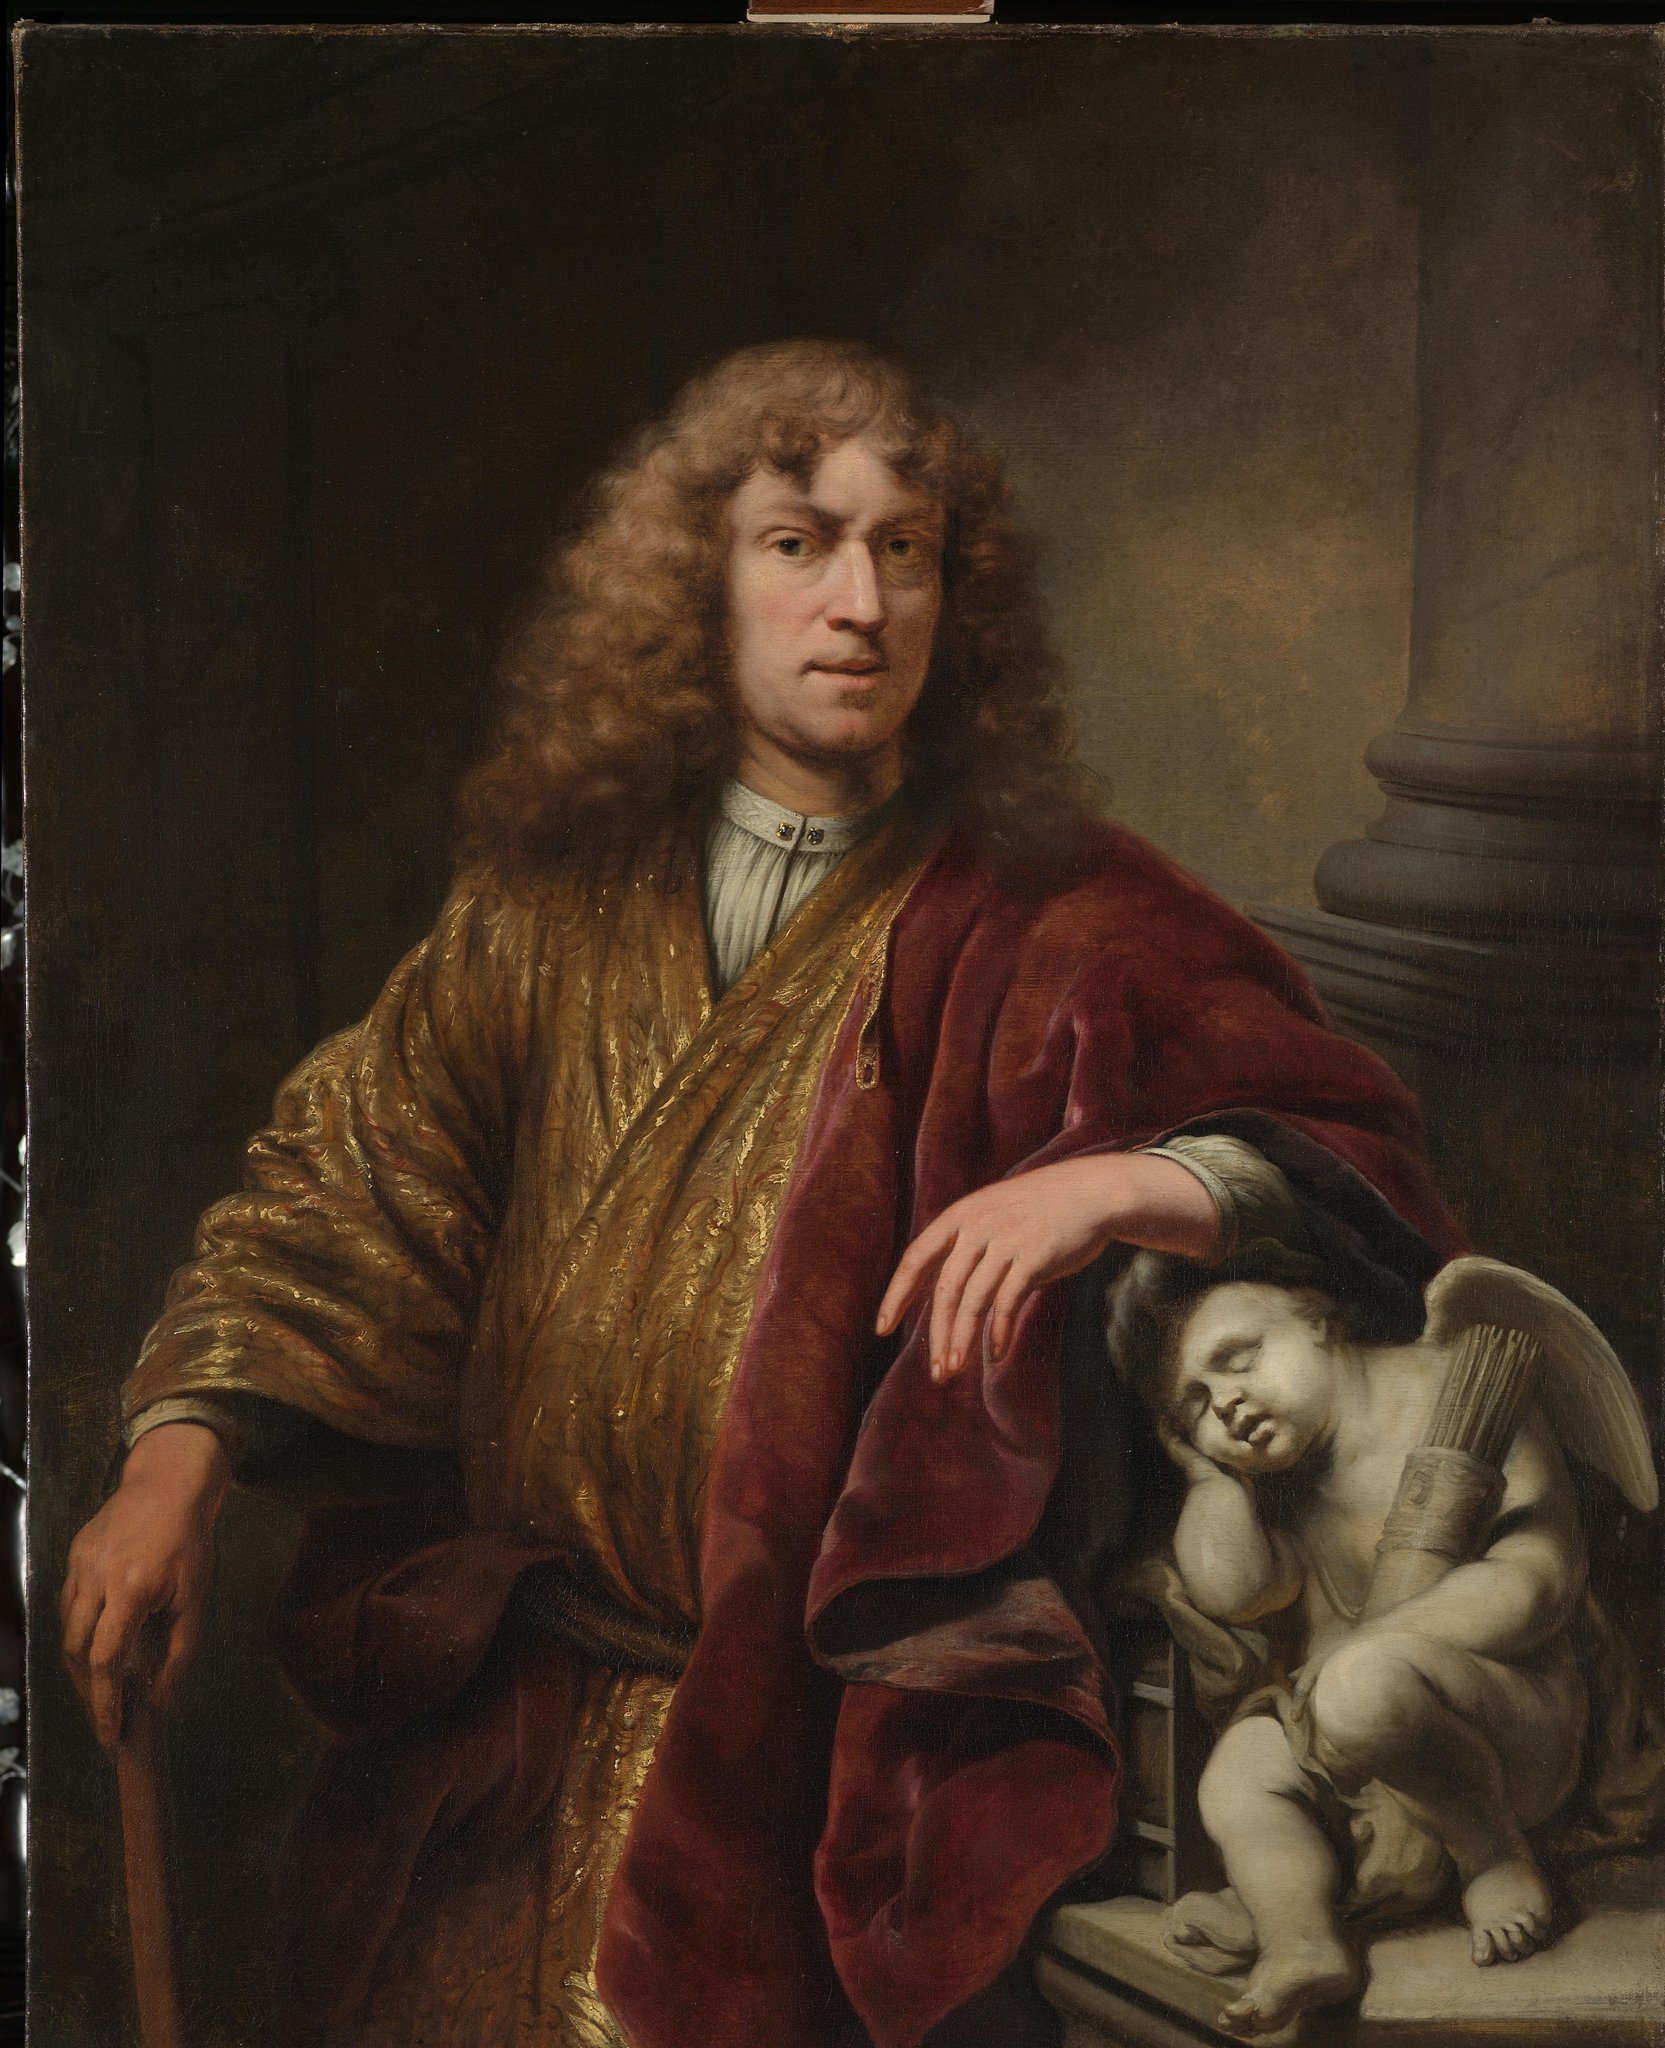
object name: painting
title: Self-Portrait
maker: ferdinand bol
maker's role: draughtsman, painter, print maker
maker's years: 1616-1680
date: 1669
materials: canvas, oil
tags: dordrecht, amsterdam, draughtsman, ferdinand bol, historical persons, portrait, self-portrait of painter, piece of sculpture, reproduction of a piece of sculpture, portrait, self-portrait of artist, sleeping cupid; possibly signifying a slackening of love's influence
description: Wearing an embroidered Japanese dressing gown, Bol poses as a man of the world here. He probably painted this self-portrait on the occasion of his marriage to the wealthy widow Anna van Erckel, one of his earliest patrons. The gilded, ornate frame was specially made for the painting. Its large carved sunflowers symbolize marriage: they trail the sun just like a person follows their beloved one.